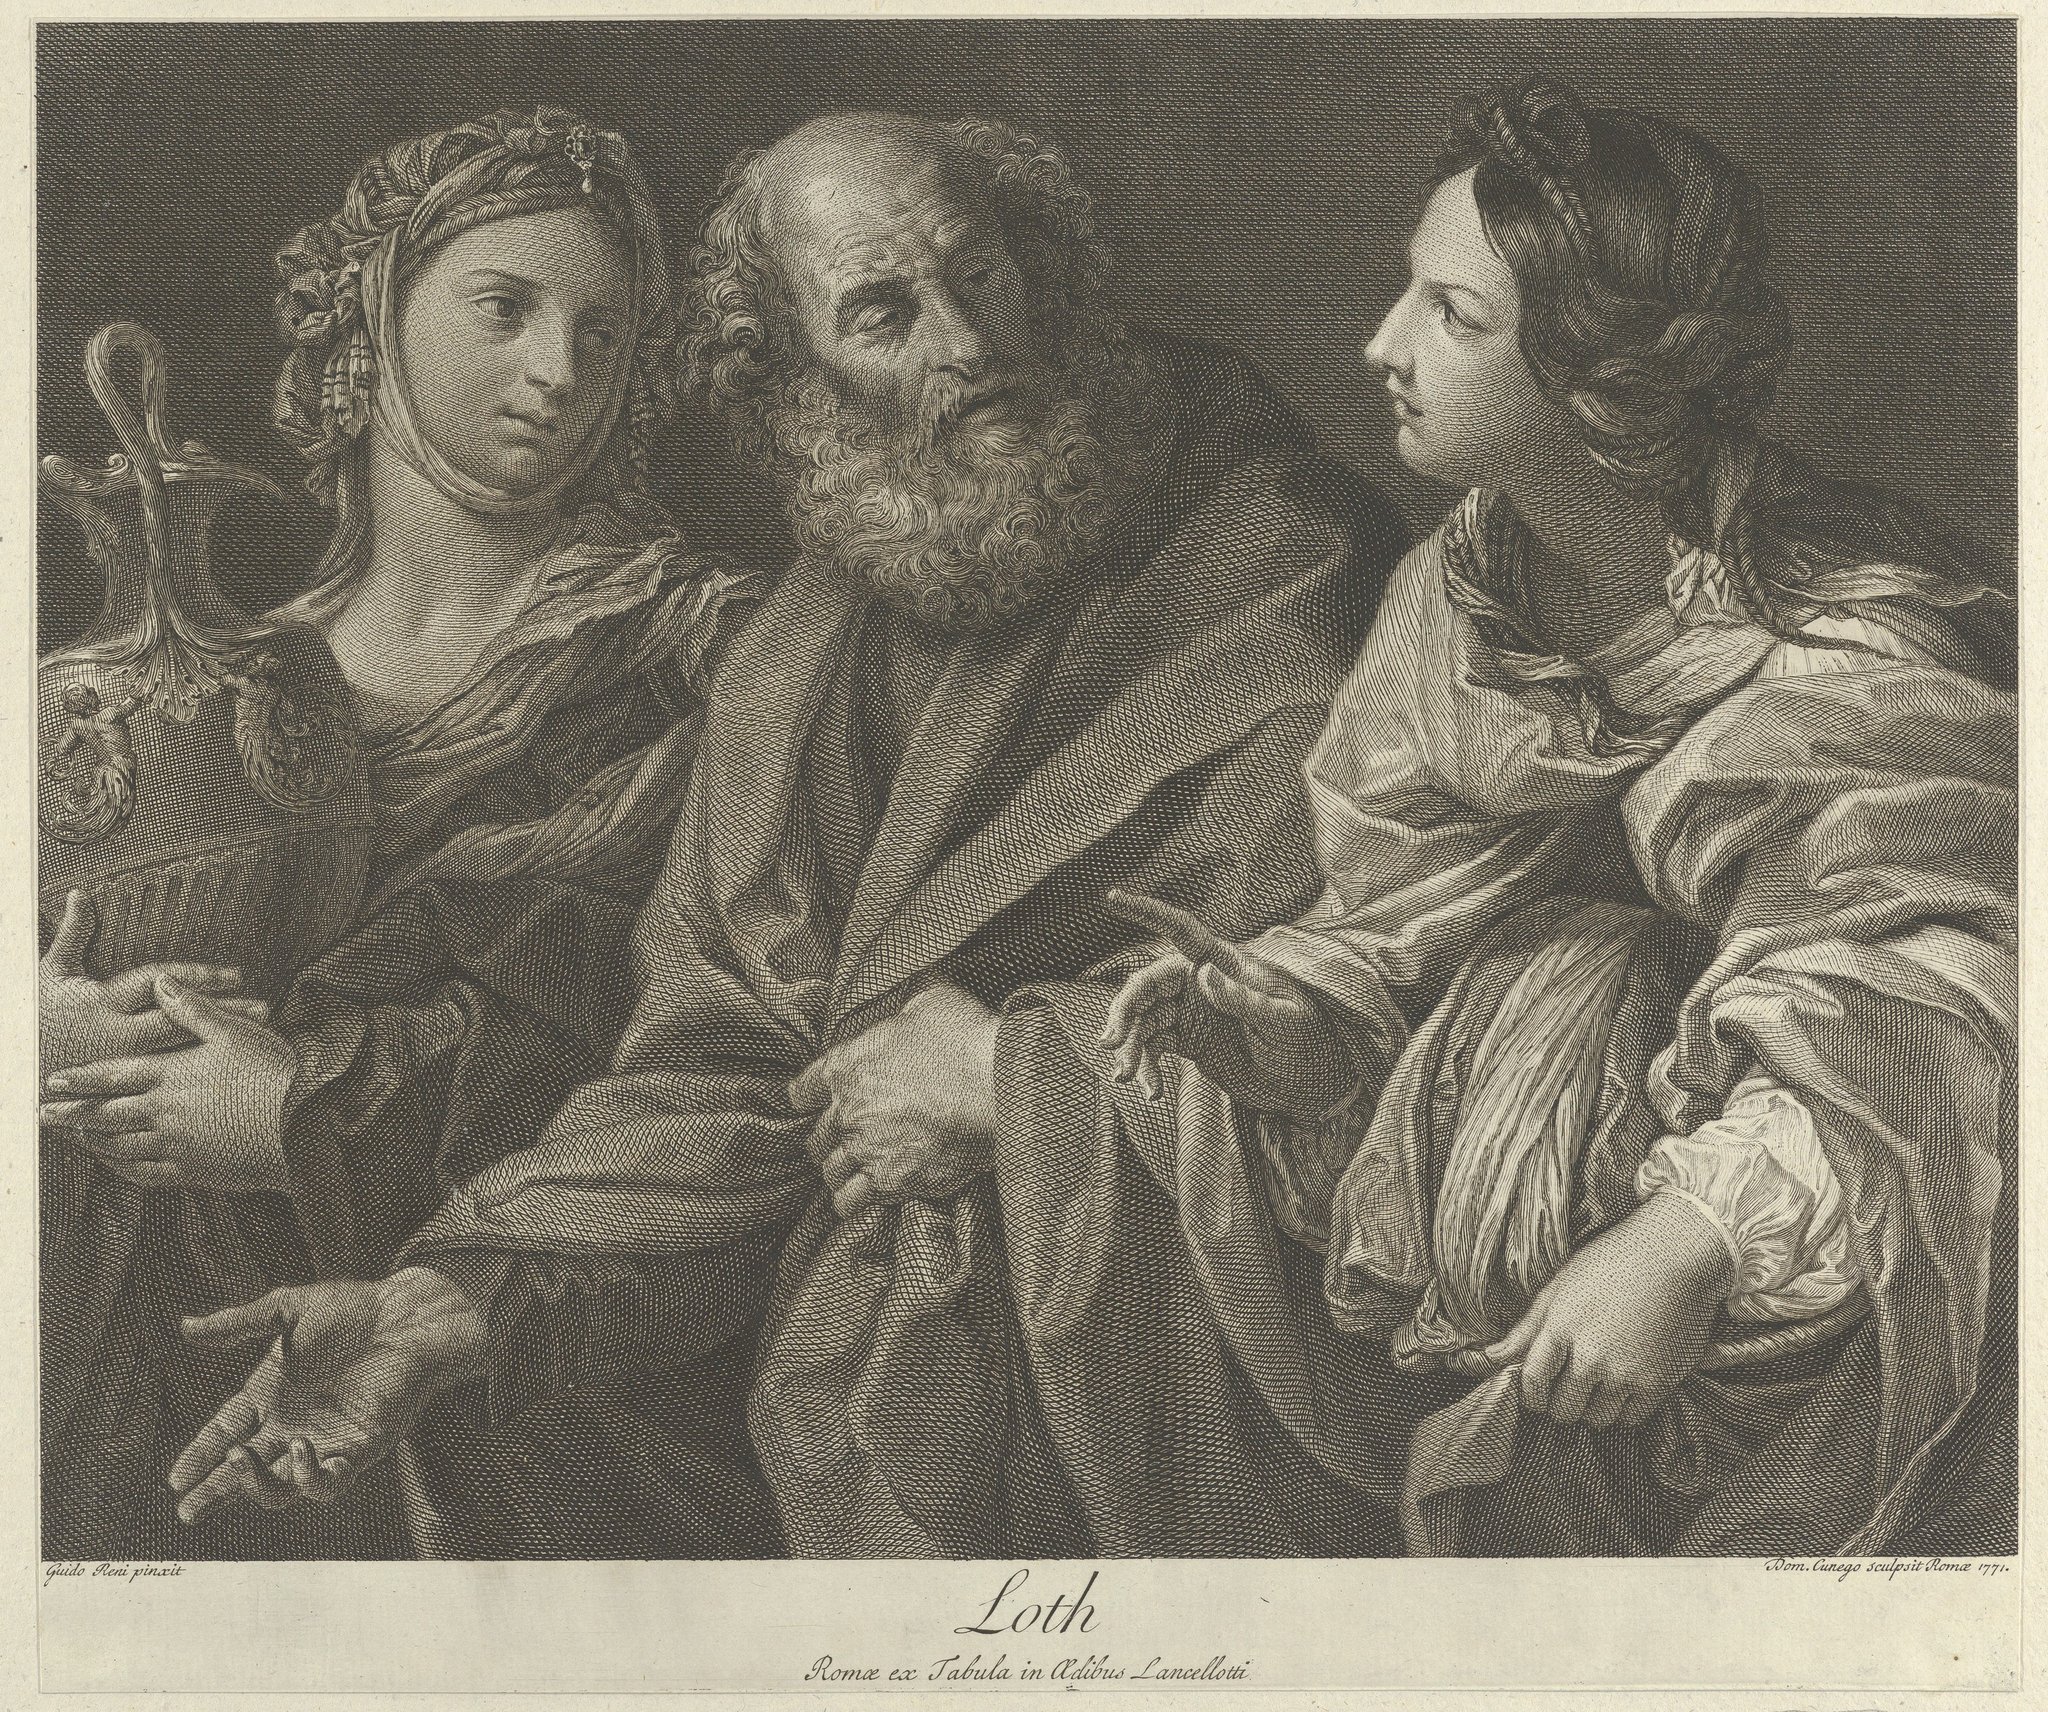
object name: print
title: Lot flanked by his two daughters, one of them holding a decorated jug, after Reni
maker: domenico cunego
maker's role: artist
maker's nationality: italian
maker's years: 1727-1803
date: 1771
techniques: engraving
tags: men,women